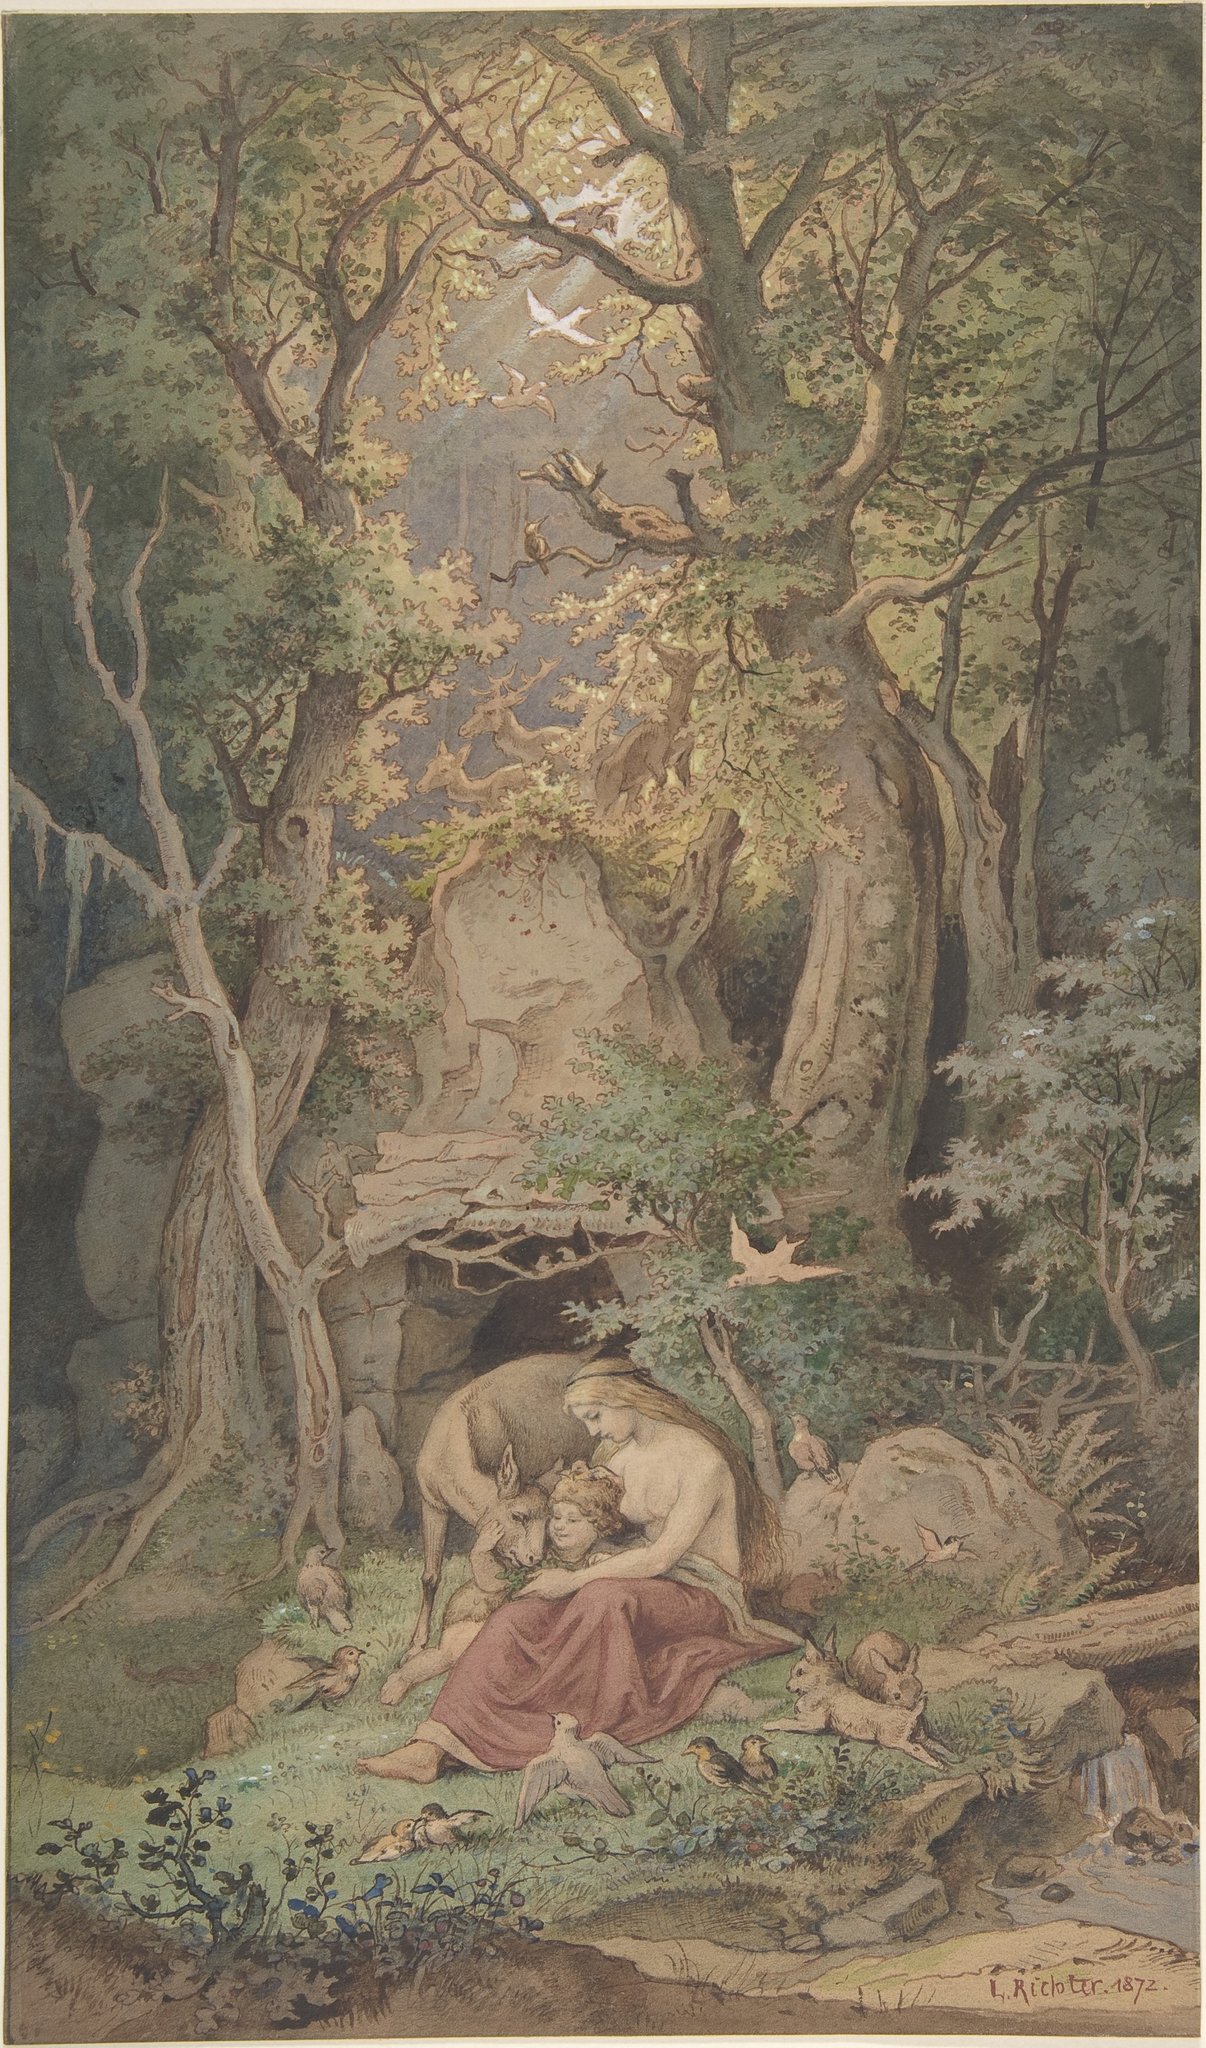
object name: drawing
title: Genoveva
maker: adrian ludwig richter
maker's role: artist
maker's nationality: german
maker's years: 1803-1884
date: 1872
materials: paper, watercolor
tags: birds,children,women,rabbits,forests